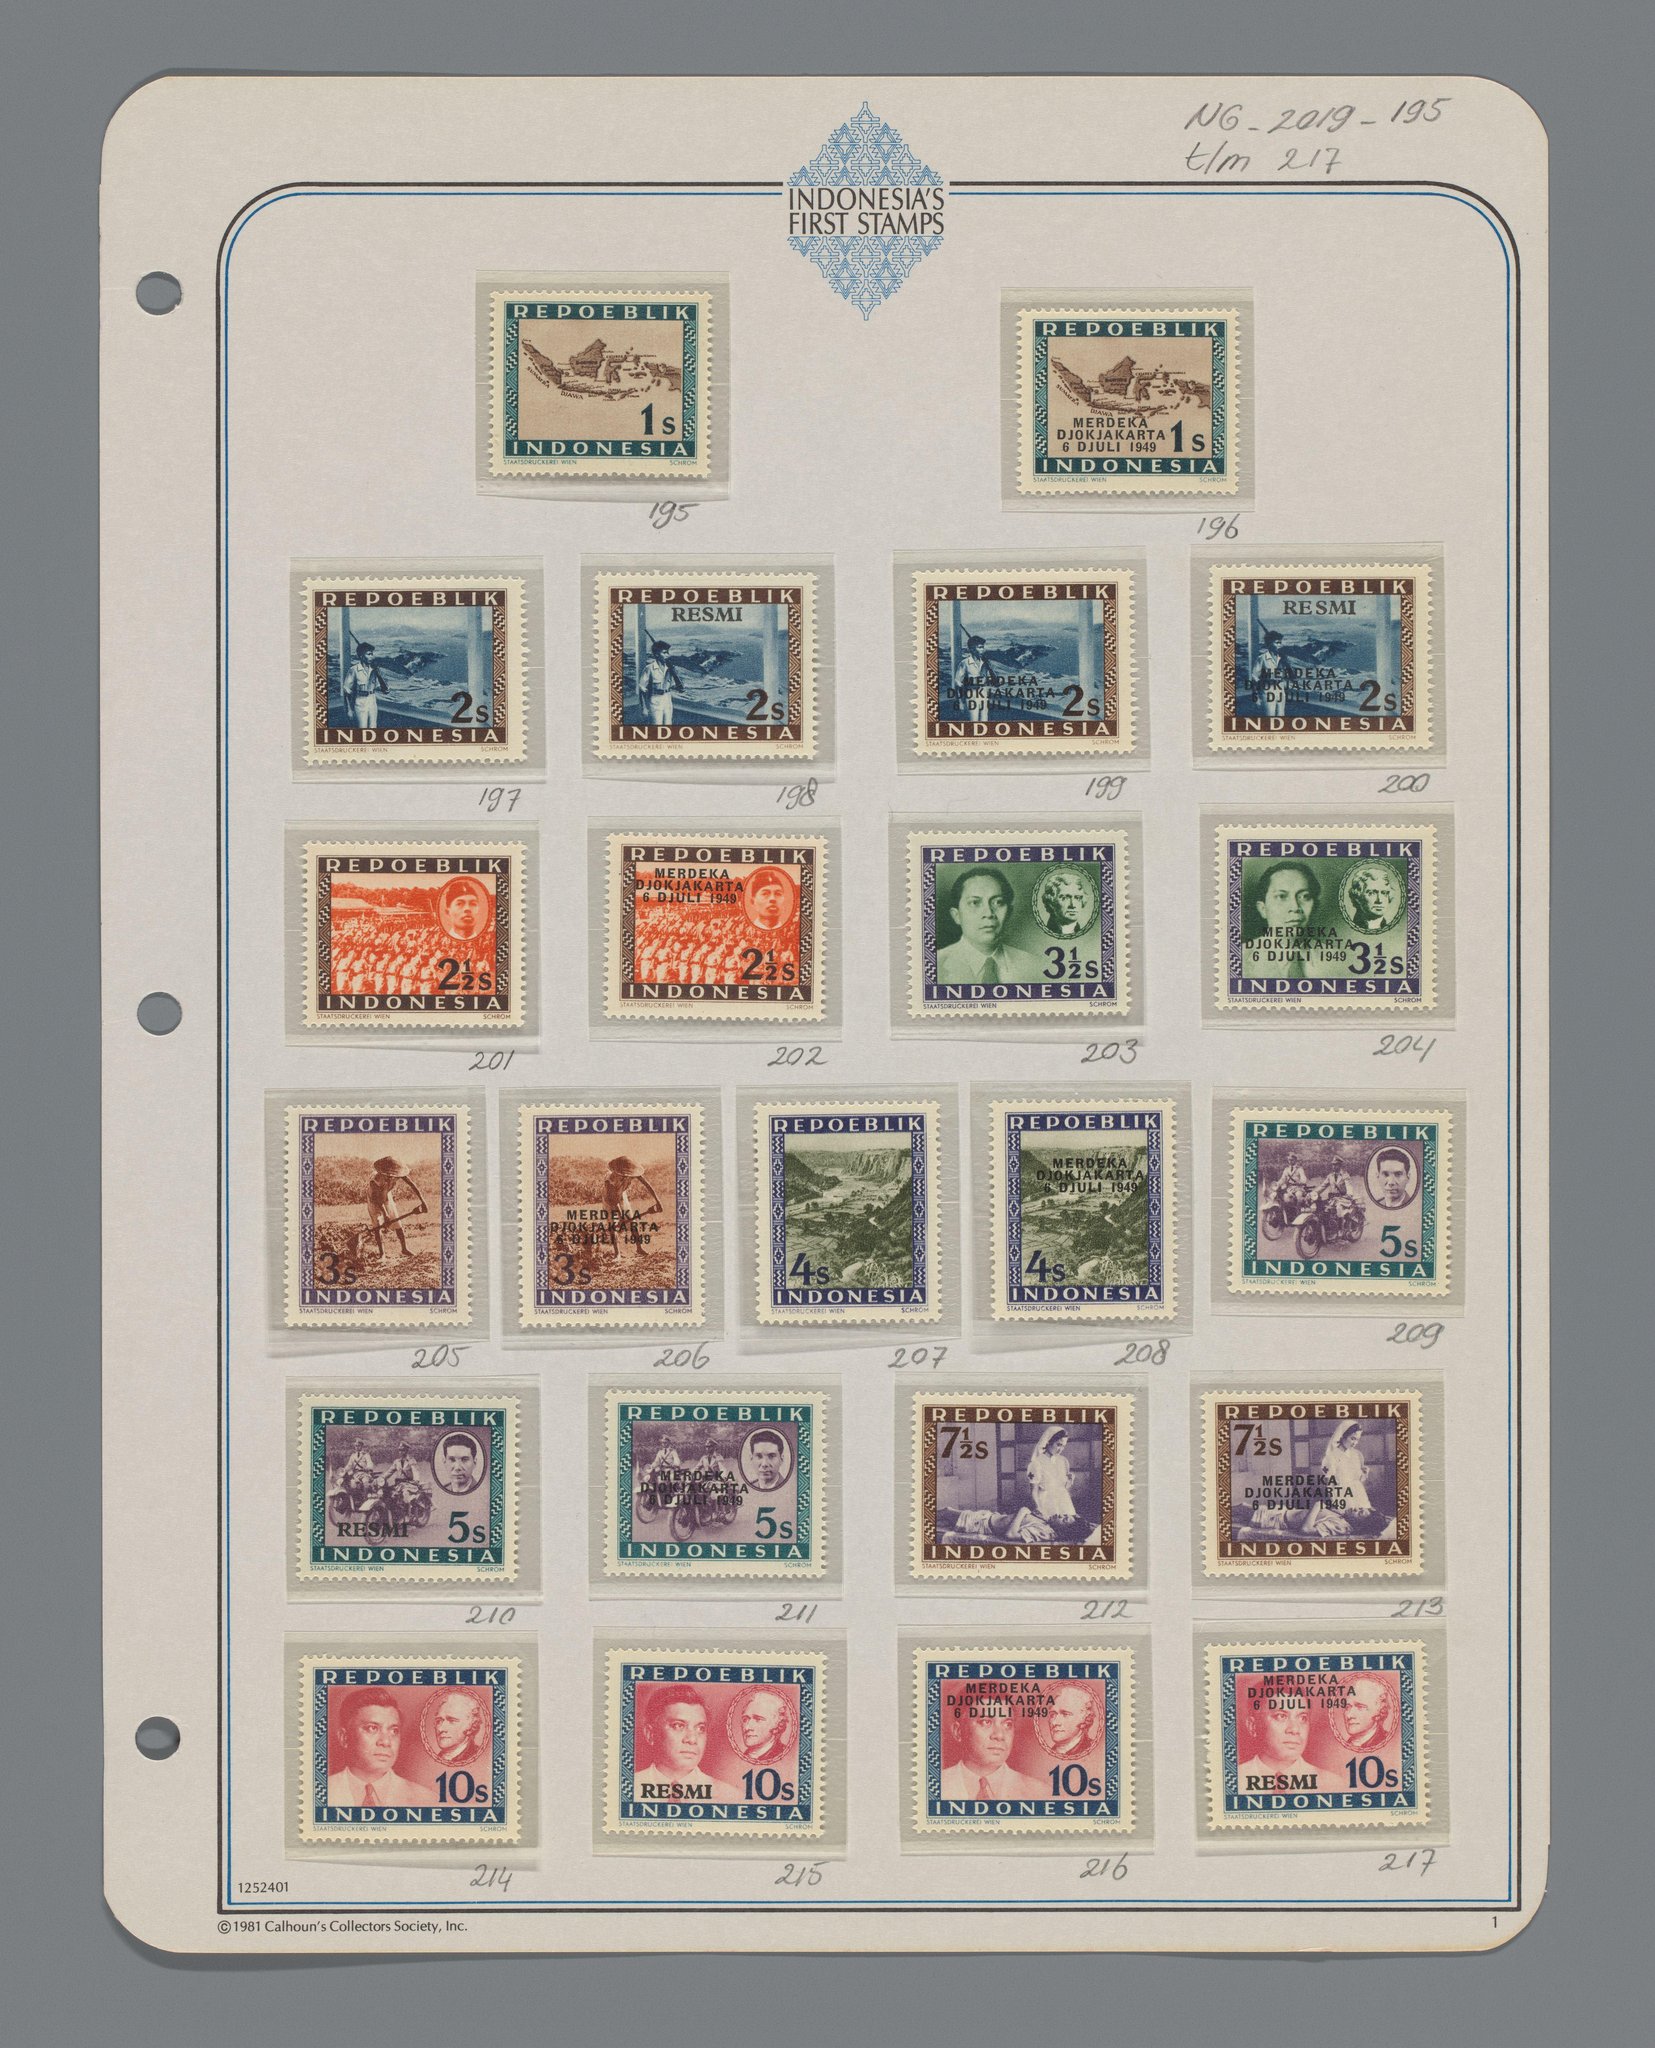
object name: postage stamp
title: Postzegel Republik Indonesia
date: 1949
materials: paper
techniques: photoaquatint, engraving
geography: vienna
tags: indonesia